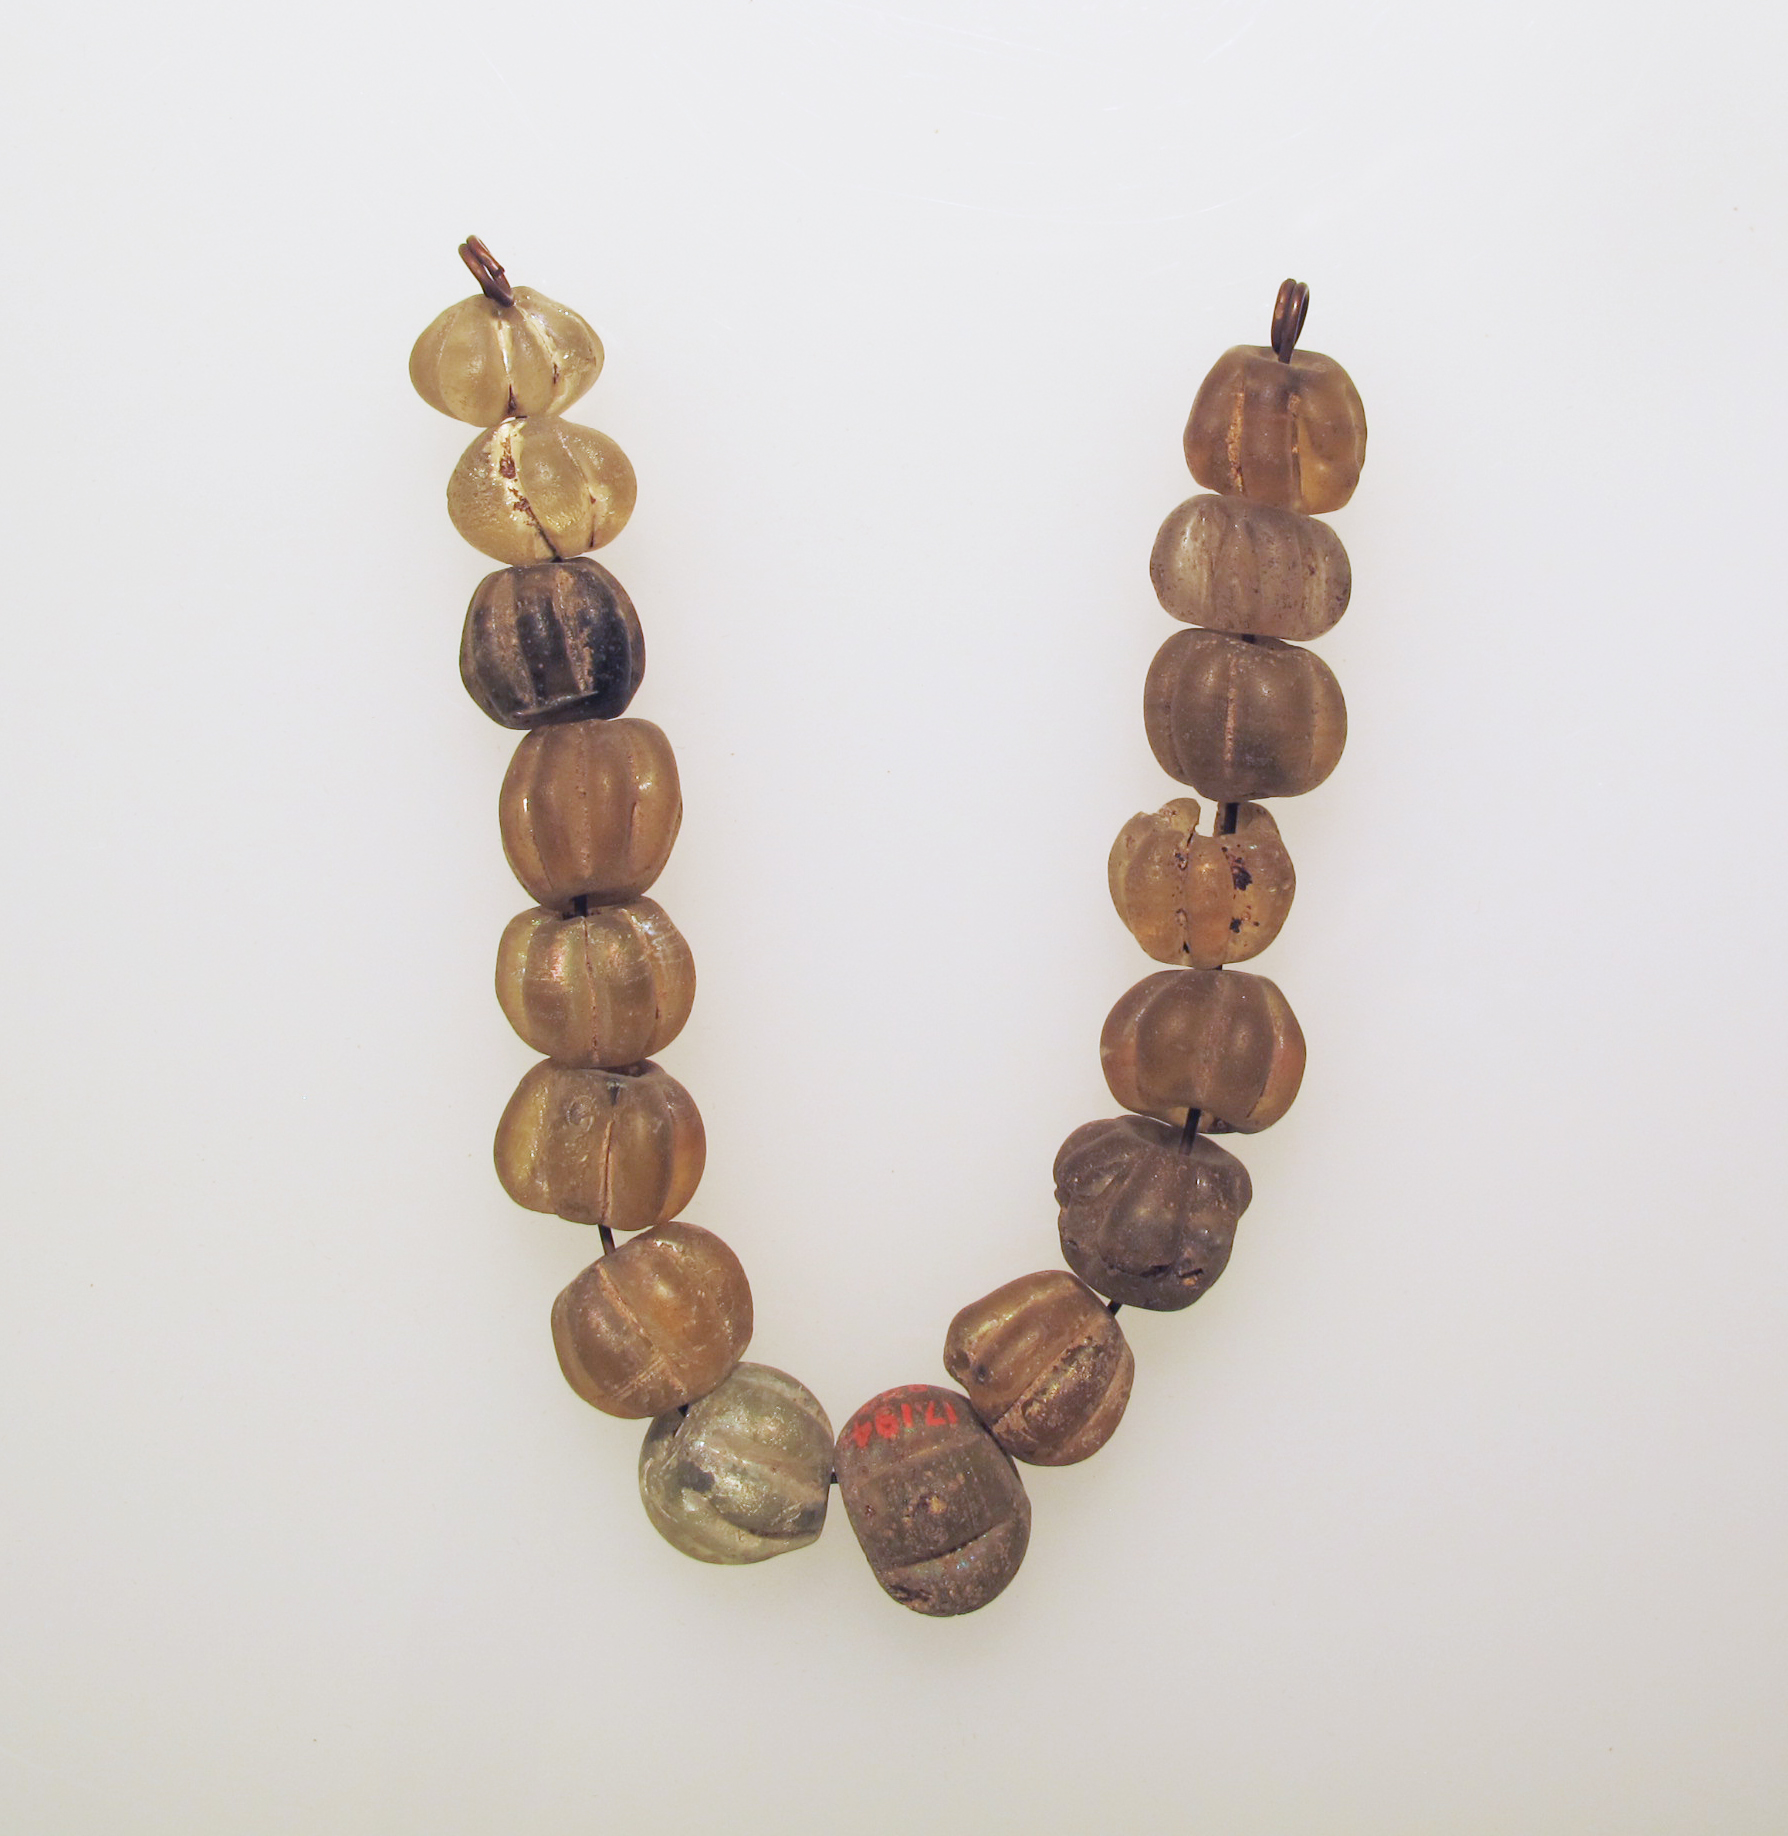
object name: bead, 16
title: Beads, 16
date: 7000 BCE-330 CE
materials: glass